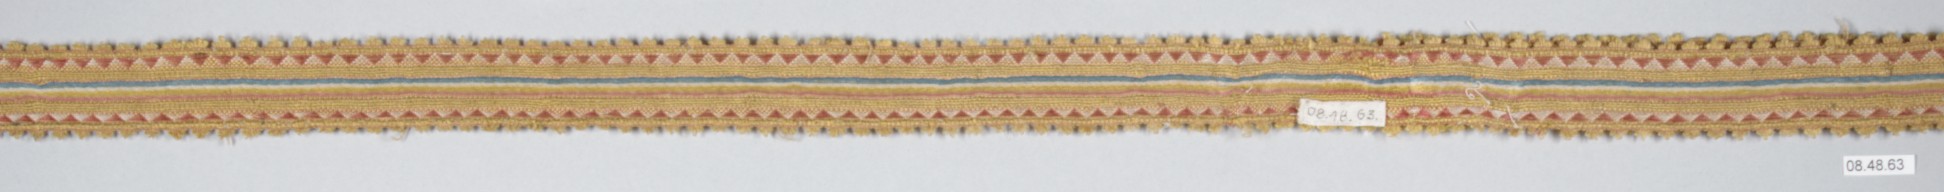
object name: galloon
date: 1801-1833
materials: silk